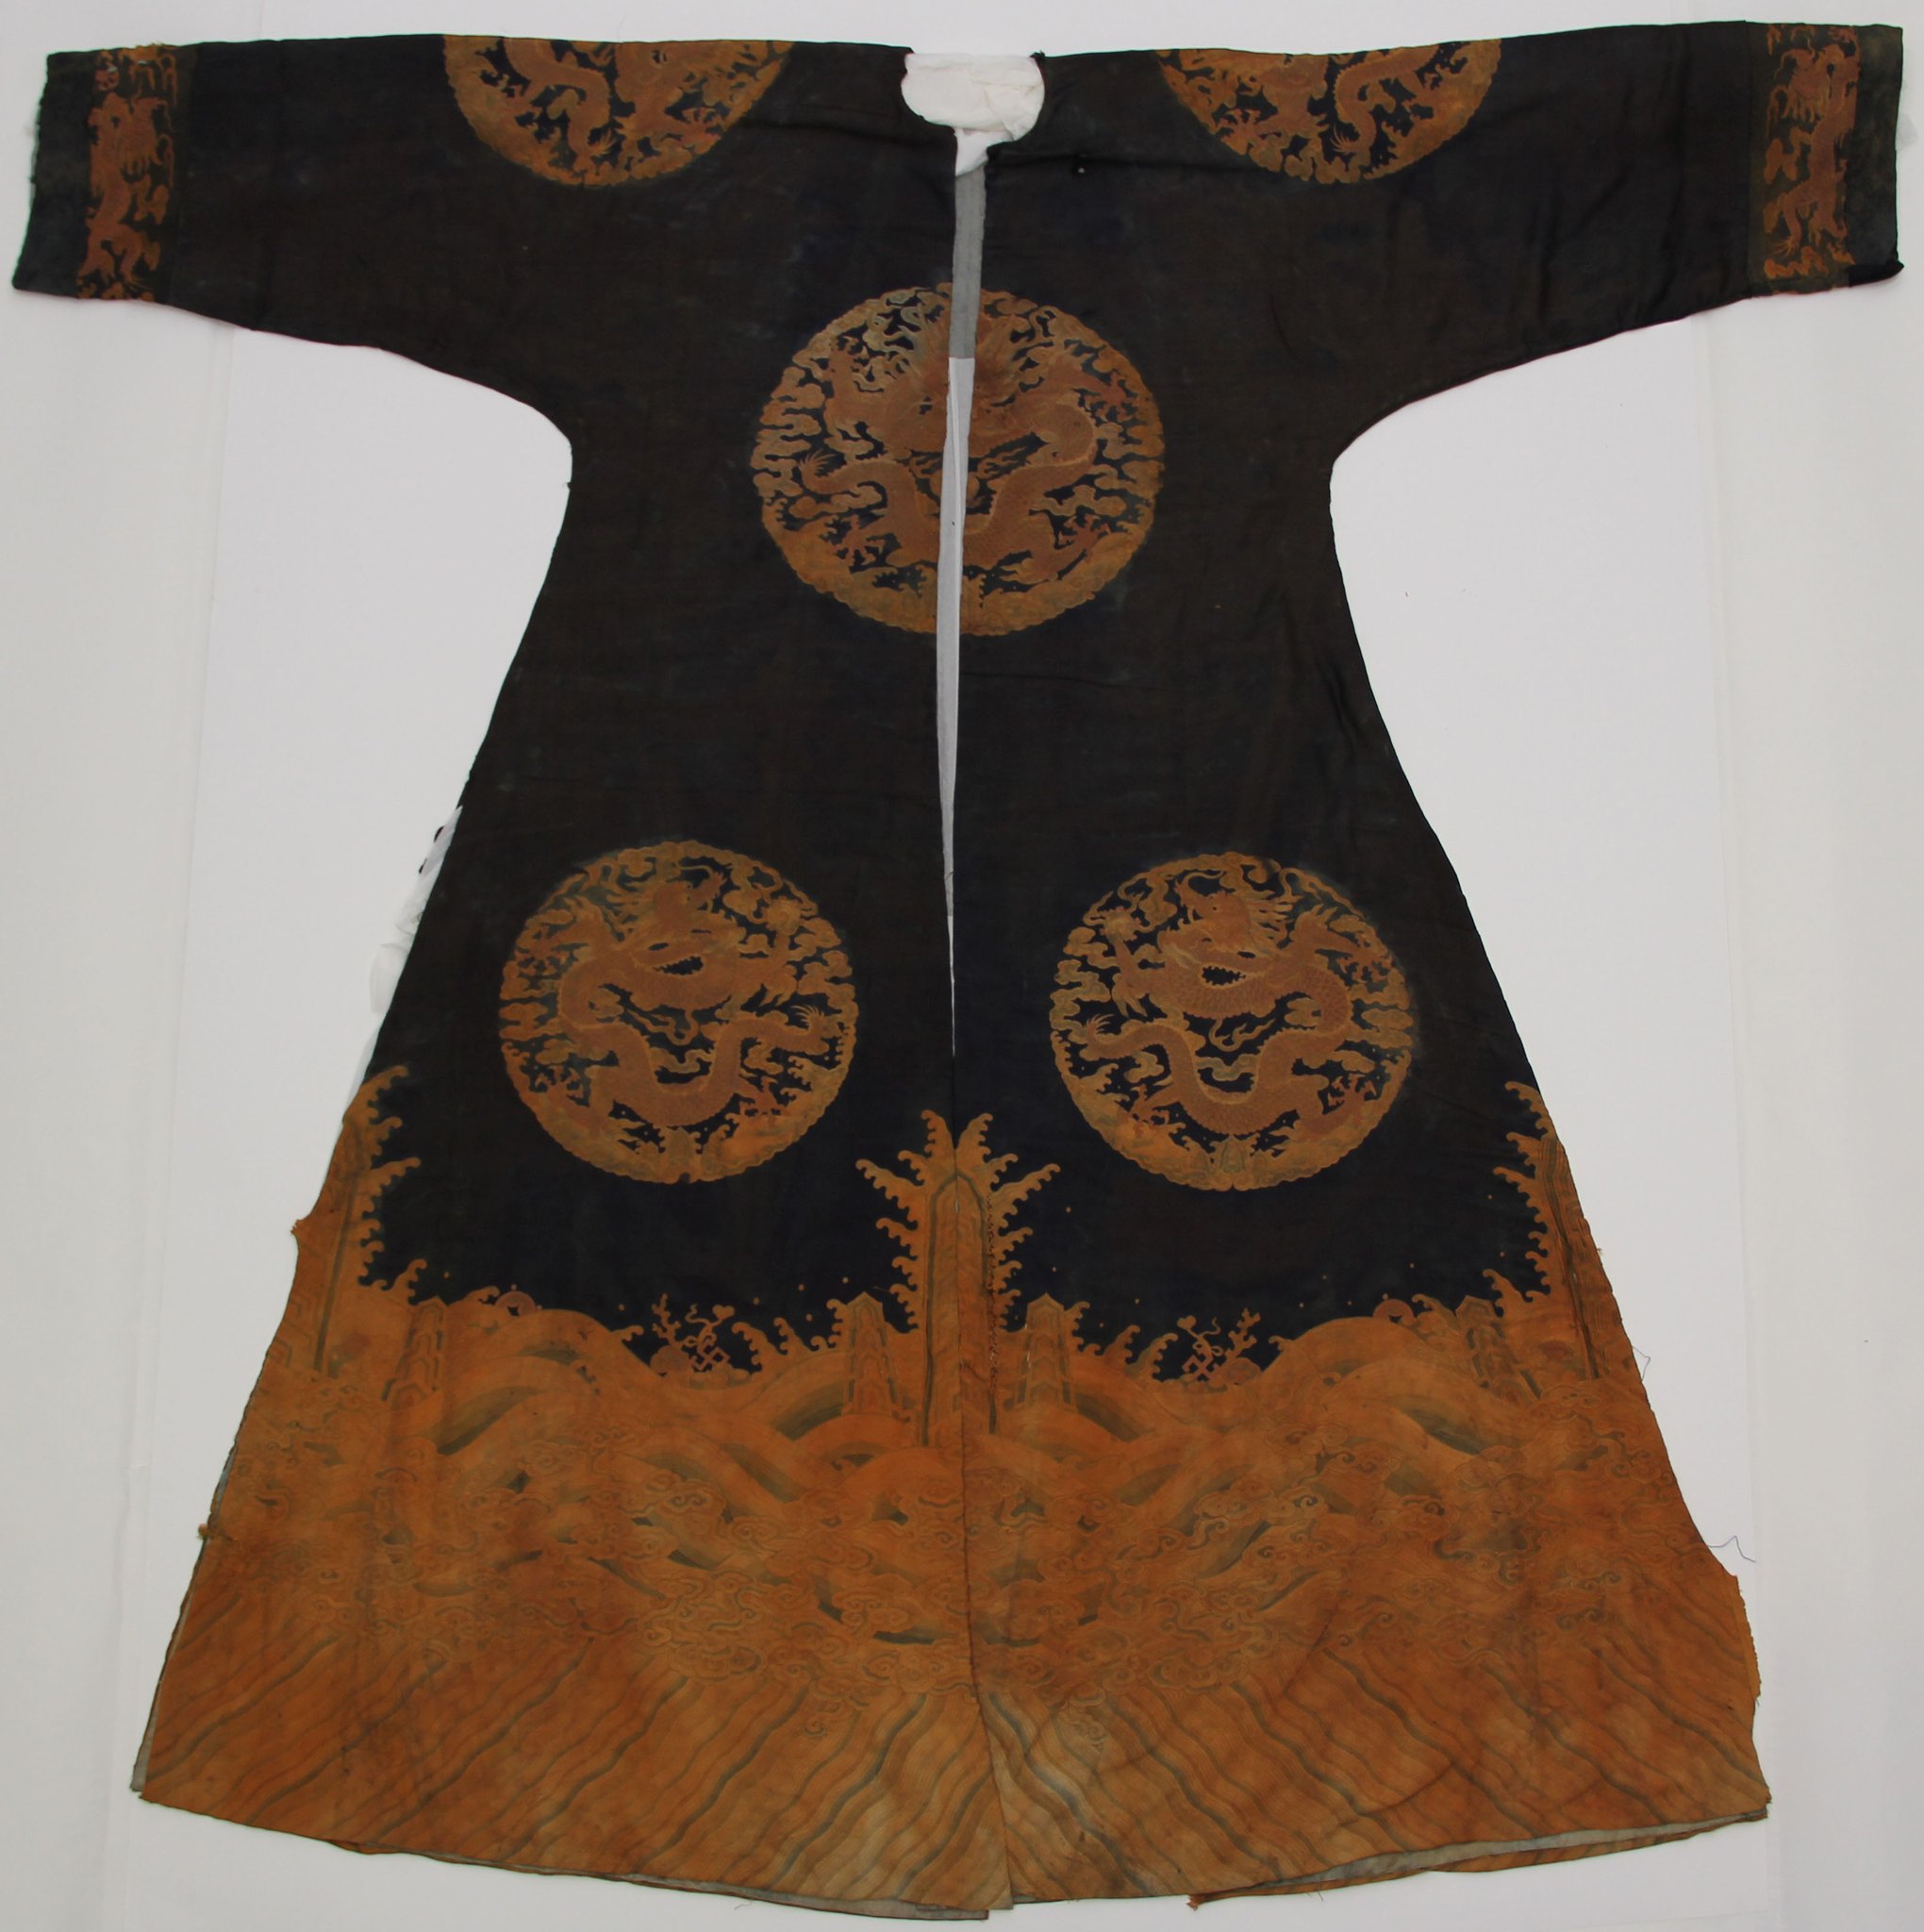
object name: woman's court overcoat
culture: chinese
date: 1723-1735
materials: metal thread, silk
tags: dragons